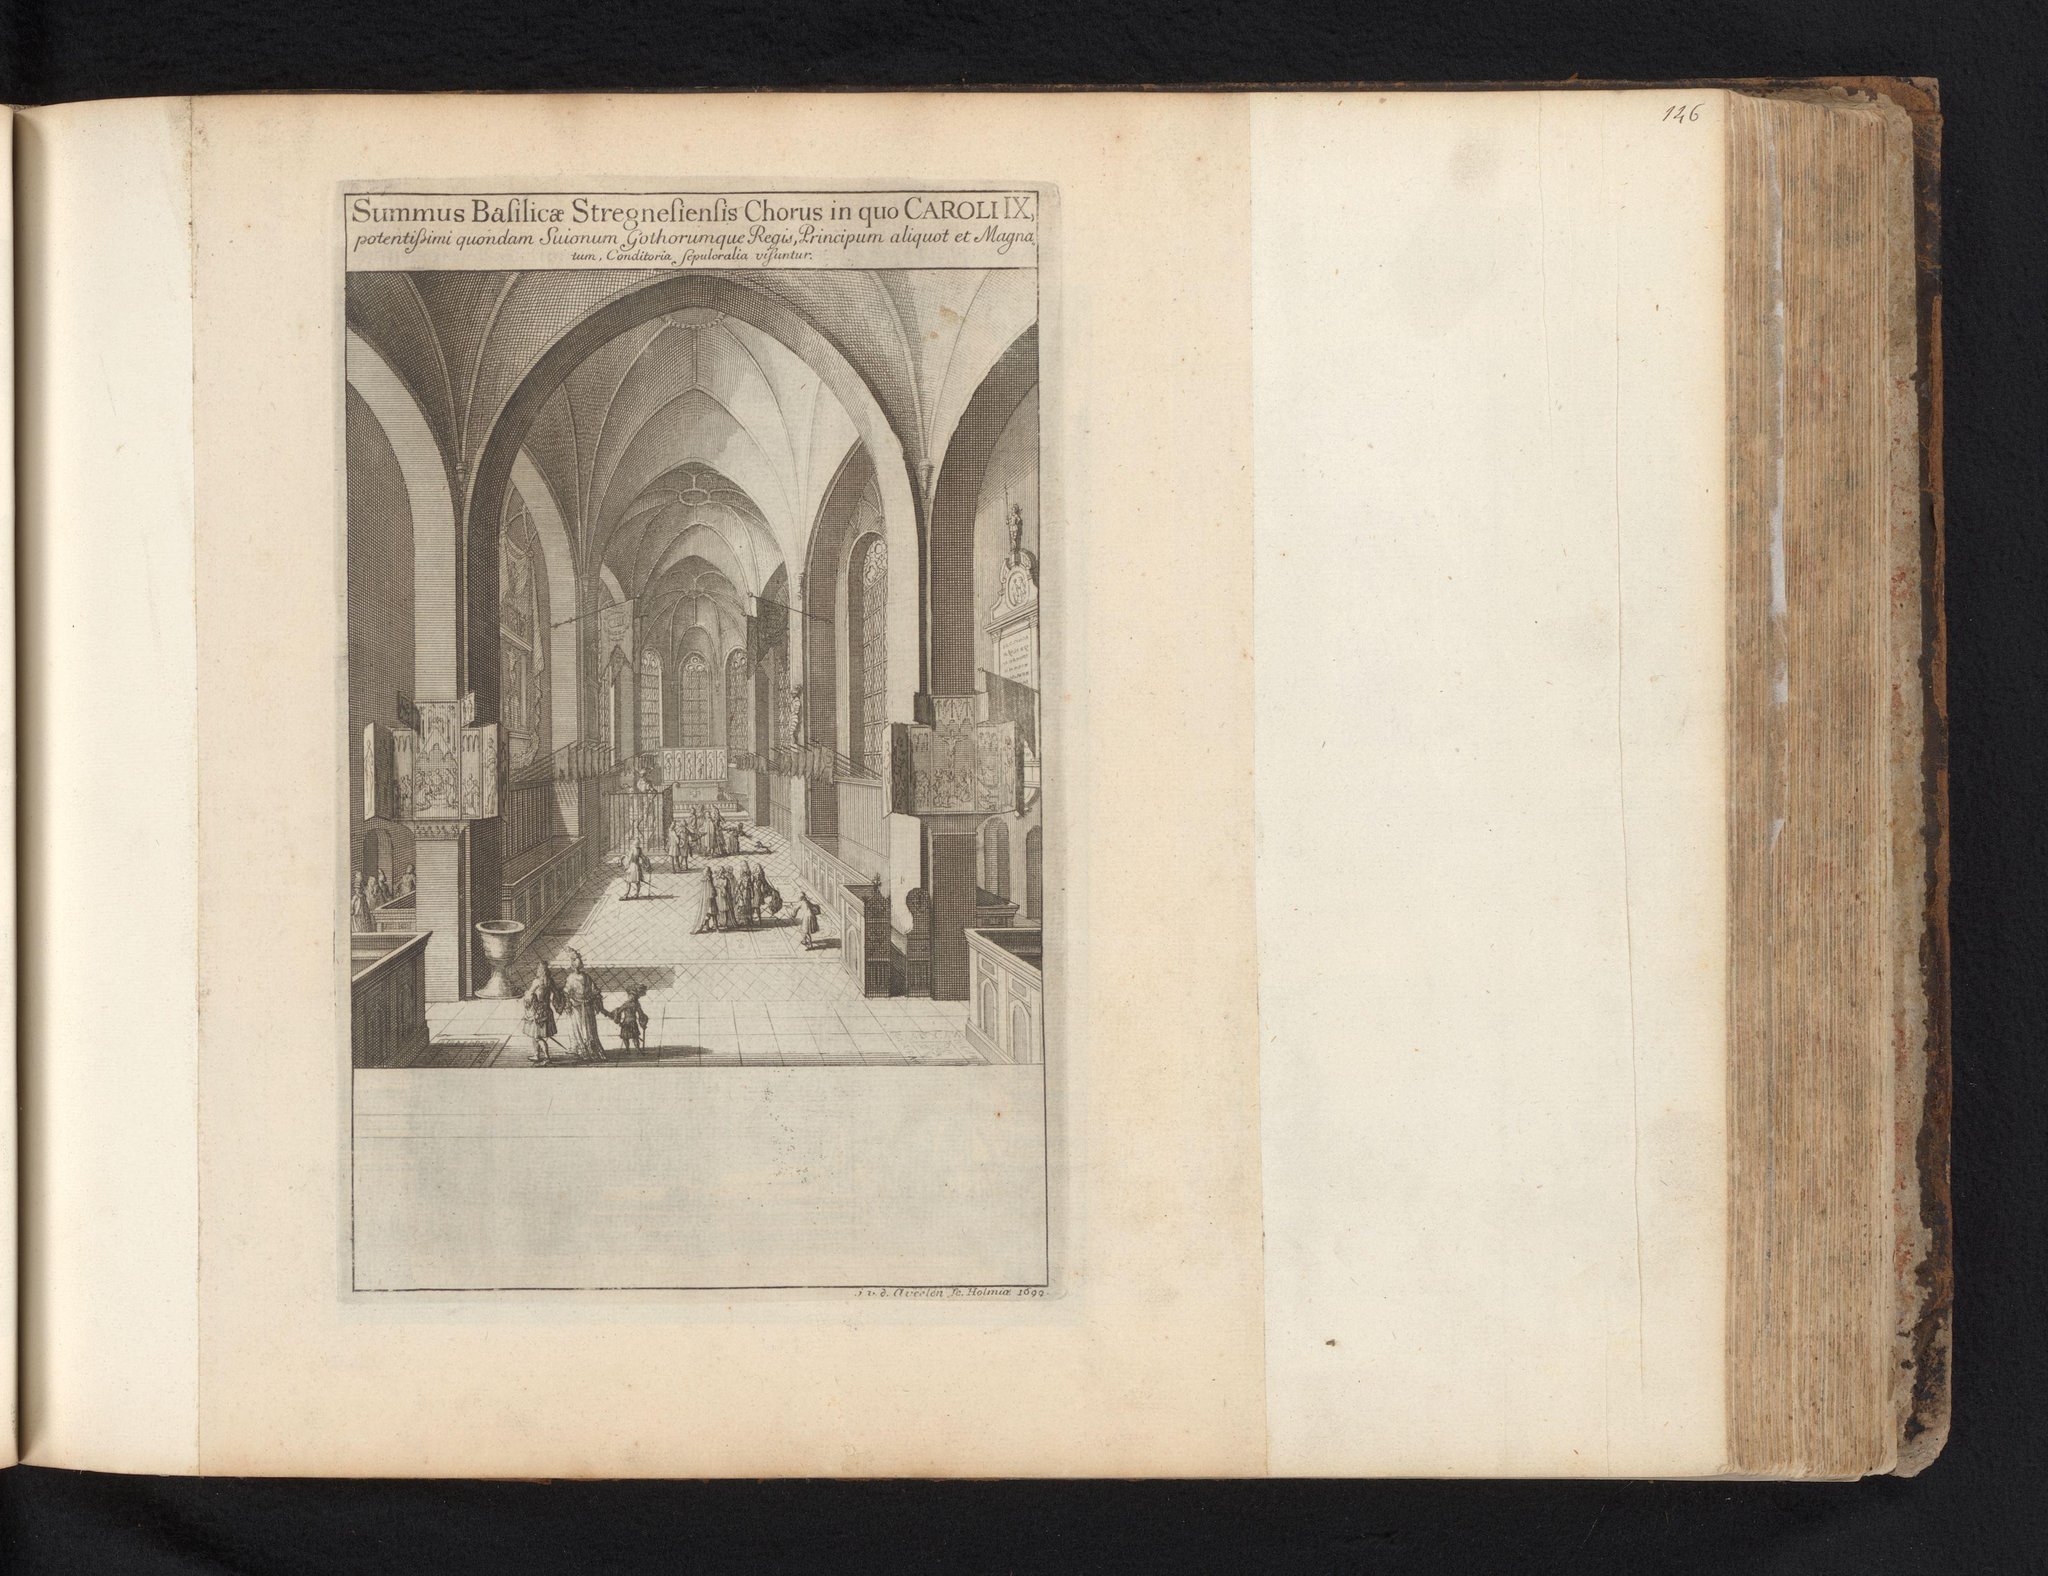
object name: album leaf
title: Summus Basilicae Strengnesiensis Chorus in quo Caroli IX (...)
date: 1699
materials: paper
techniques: etching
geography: stockholm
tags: interior of church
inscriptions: date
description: Kungliga Biblioteket, 'Suecia': http://www.kb.se/samlingarna/Kartor-bilder/Suecia-antiqua/ (geraadpleegd november 2016).